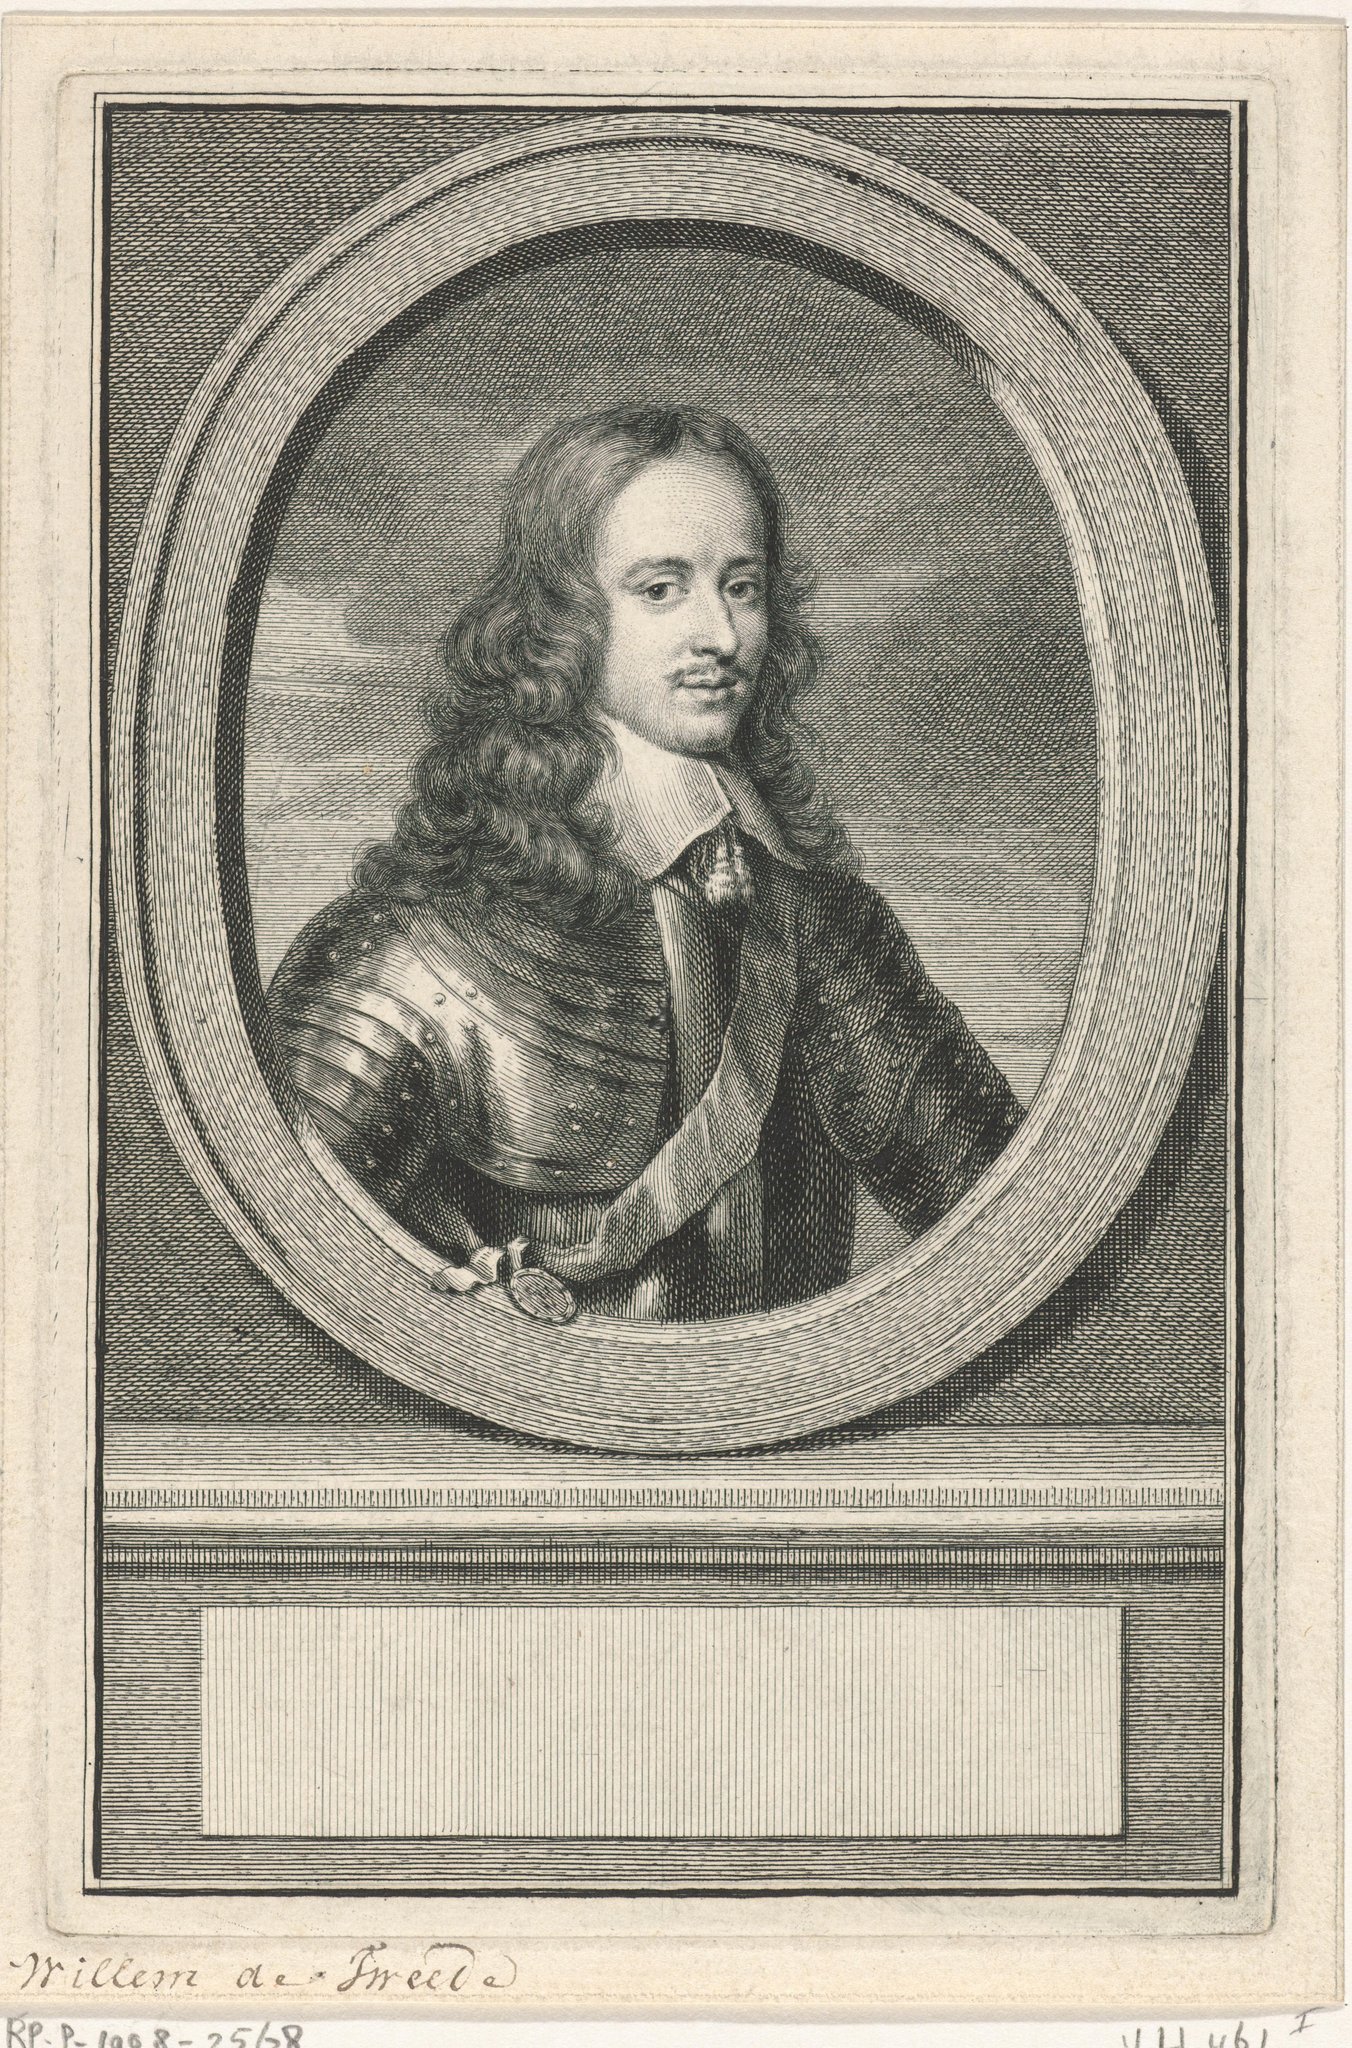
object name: print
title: Portret van Willem II, prins van Oranje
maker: jacob houbraken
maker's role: draughtsman, print maker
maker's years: 1698-1780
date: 1747-1759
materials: paper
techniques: engraving, pen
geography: amsterdam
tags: william ii (prince of orange)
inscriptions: name: ‘Willem de Tweede’, collector's mark: Lugt 2228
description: Proefdruk van de prent gebruikt in: Jan Wagenaar, Vaderlandsche historie, vervattende de geschiedenissen der nu Vereenigde Nederlanden, inzonderheid die van Holland (...), 21 delen. Amsterdam, Isaak Tirion, 1749-59.